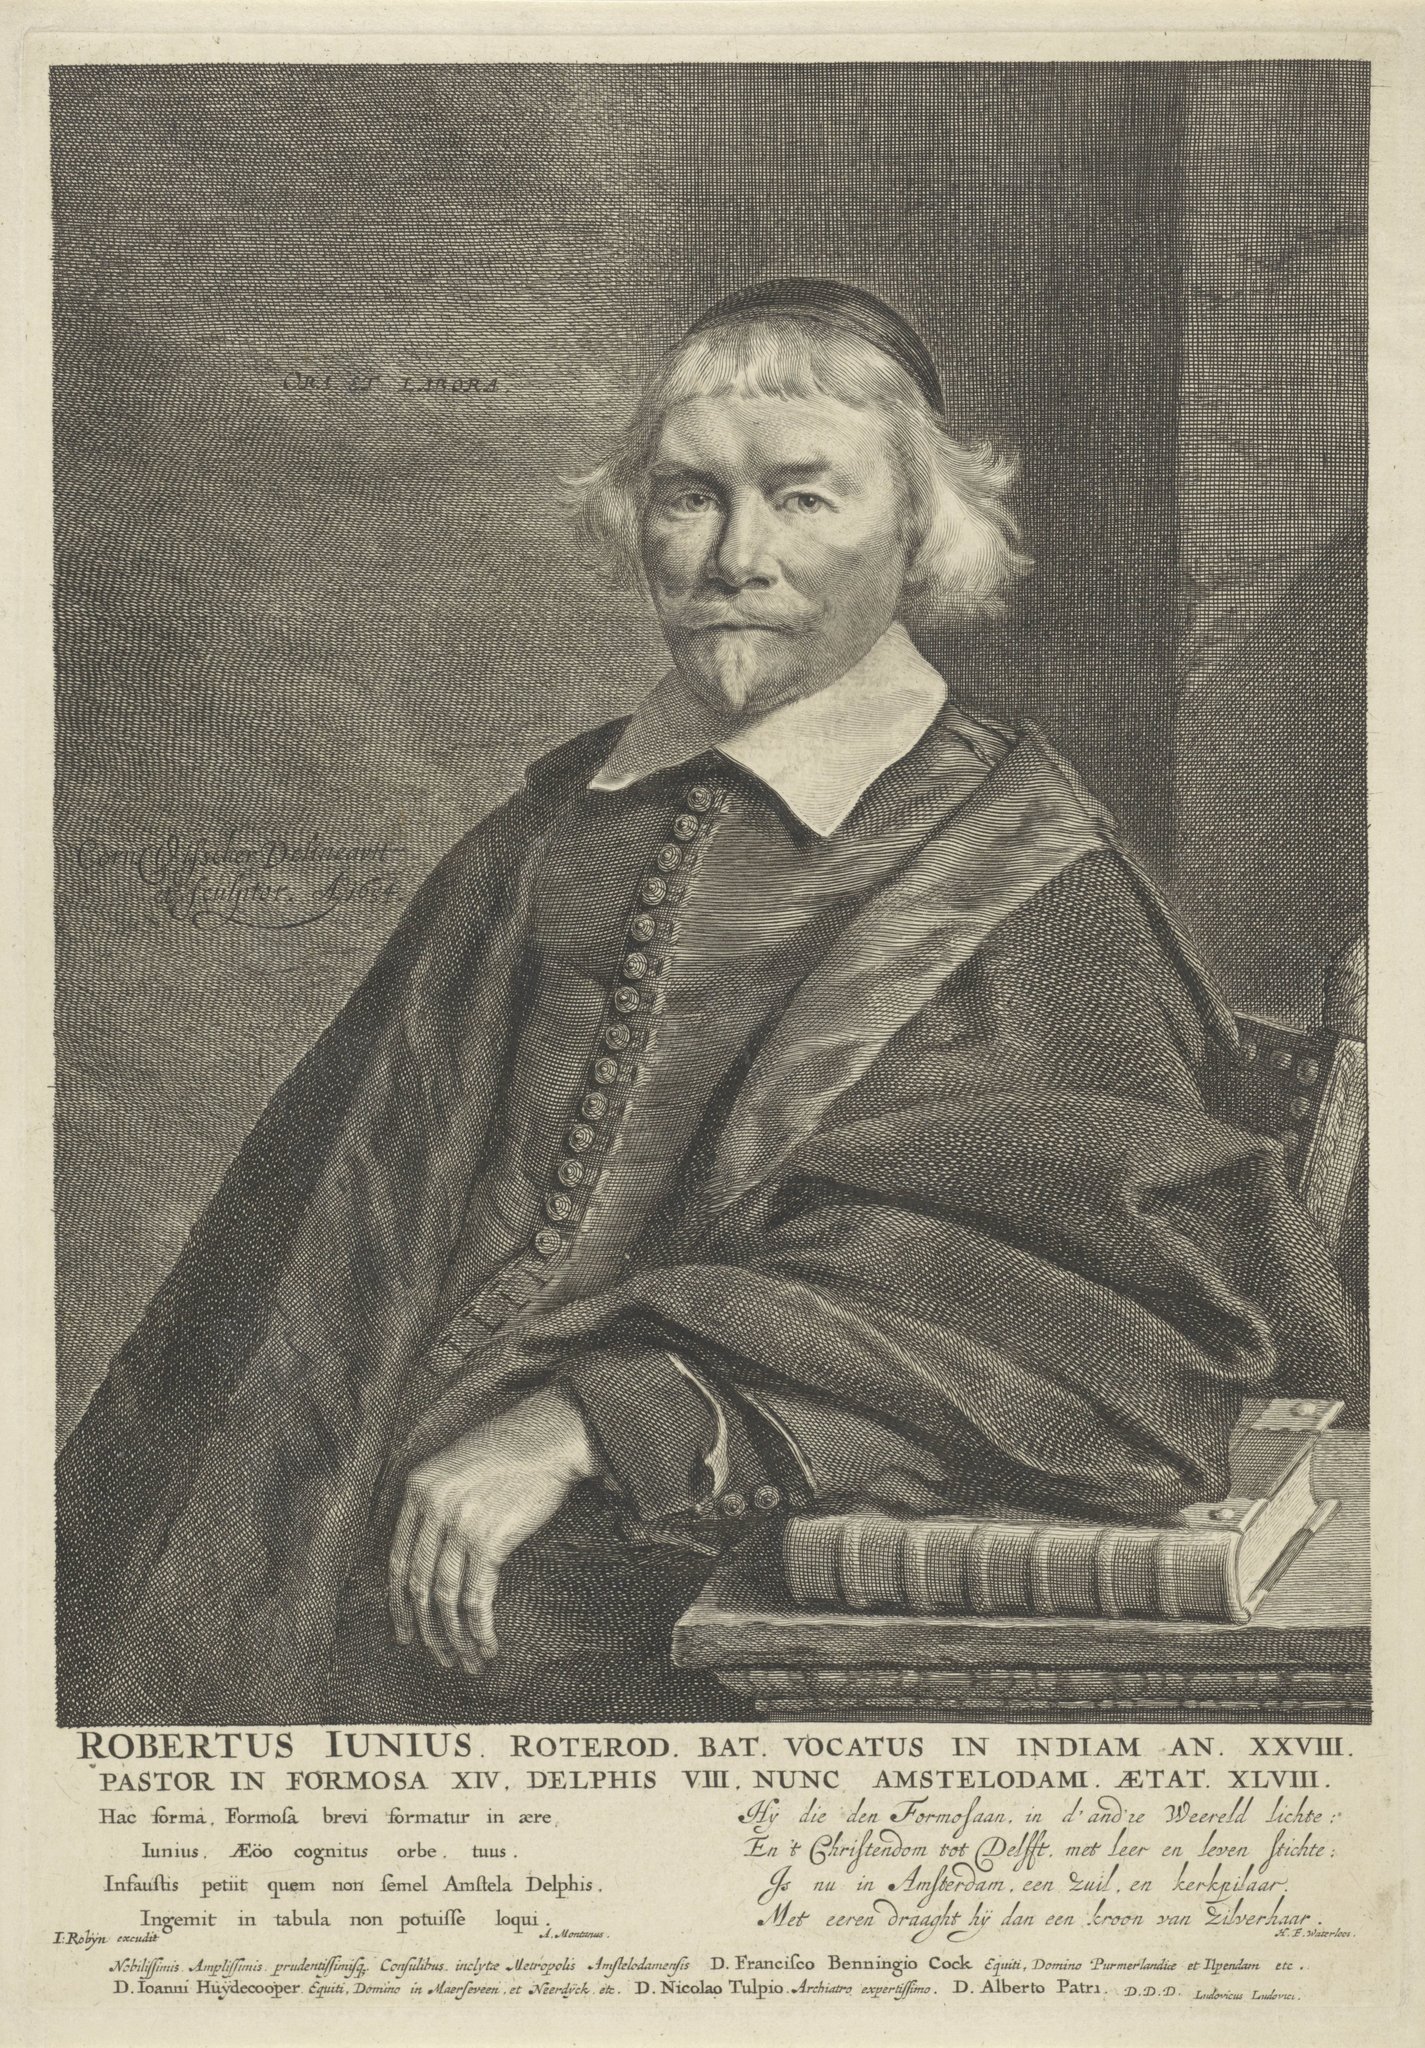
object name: print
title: Portret van Robert Junius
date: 1676-1707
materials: paper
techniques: engraving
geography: amsterdam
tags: rotterdam, amsterdam, book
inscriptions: collector's mark: Lugt 2228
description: Robert Junius, predikant te Indië, Formosa, Delft en Amsterdam. Hij laat zijn arm op een boek rusten. In de marge een vers in het Latijn en in het Nederlands.